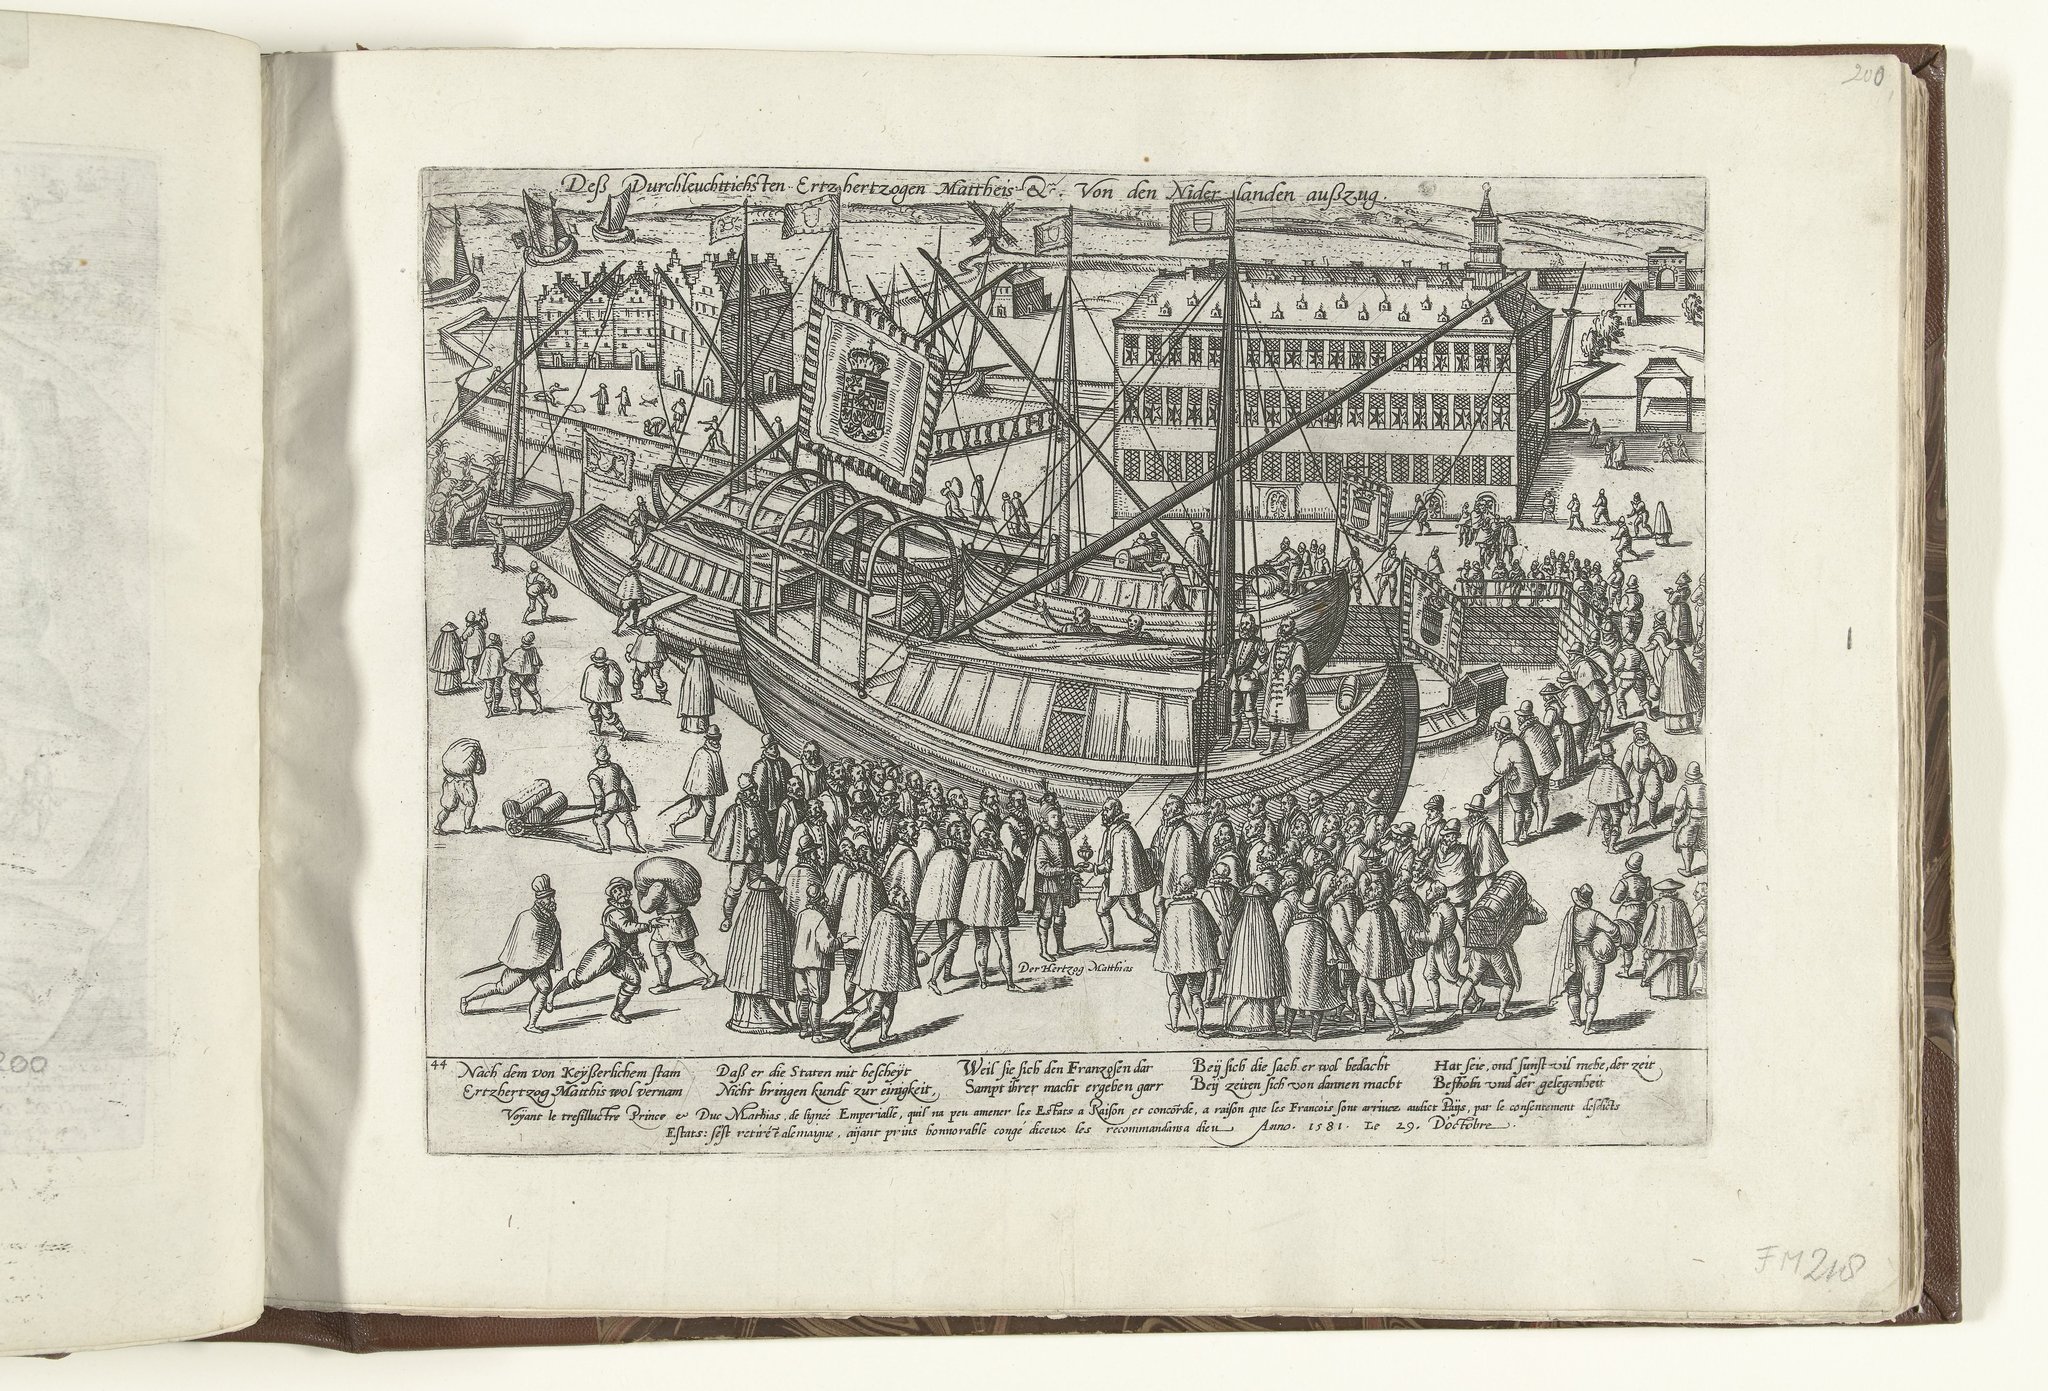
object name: print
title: Serie 8: Nederlandse Gebeurtenissen, 1577-1583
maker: frans hogenberg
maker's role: print maker, publisher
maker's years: 1538-1590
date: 1581-1583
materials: paper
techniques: etching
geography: cologne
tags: matthias van oostenrijk (rooms-duits keizer), antwerp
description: Het vertrek van aartshertog Matthias uit de Nederlanden, 29 oktober 1581. Matthias neemt afscheid op de kade van Antwerpen bij een gereed staand schip met vaandels. Met onderschrift van 10 regels in het Duits en 2 regels in het Frans. Genummerd: 44.